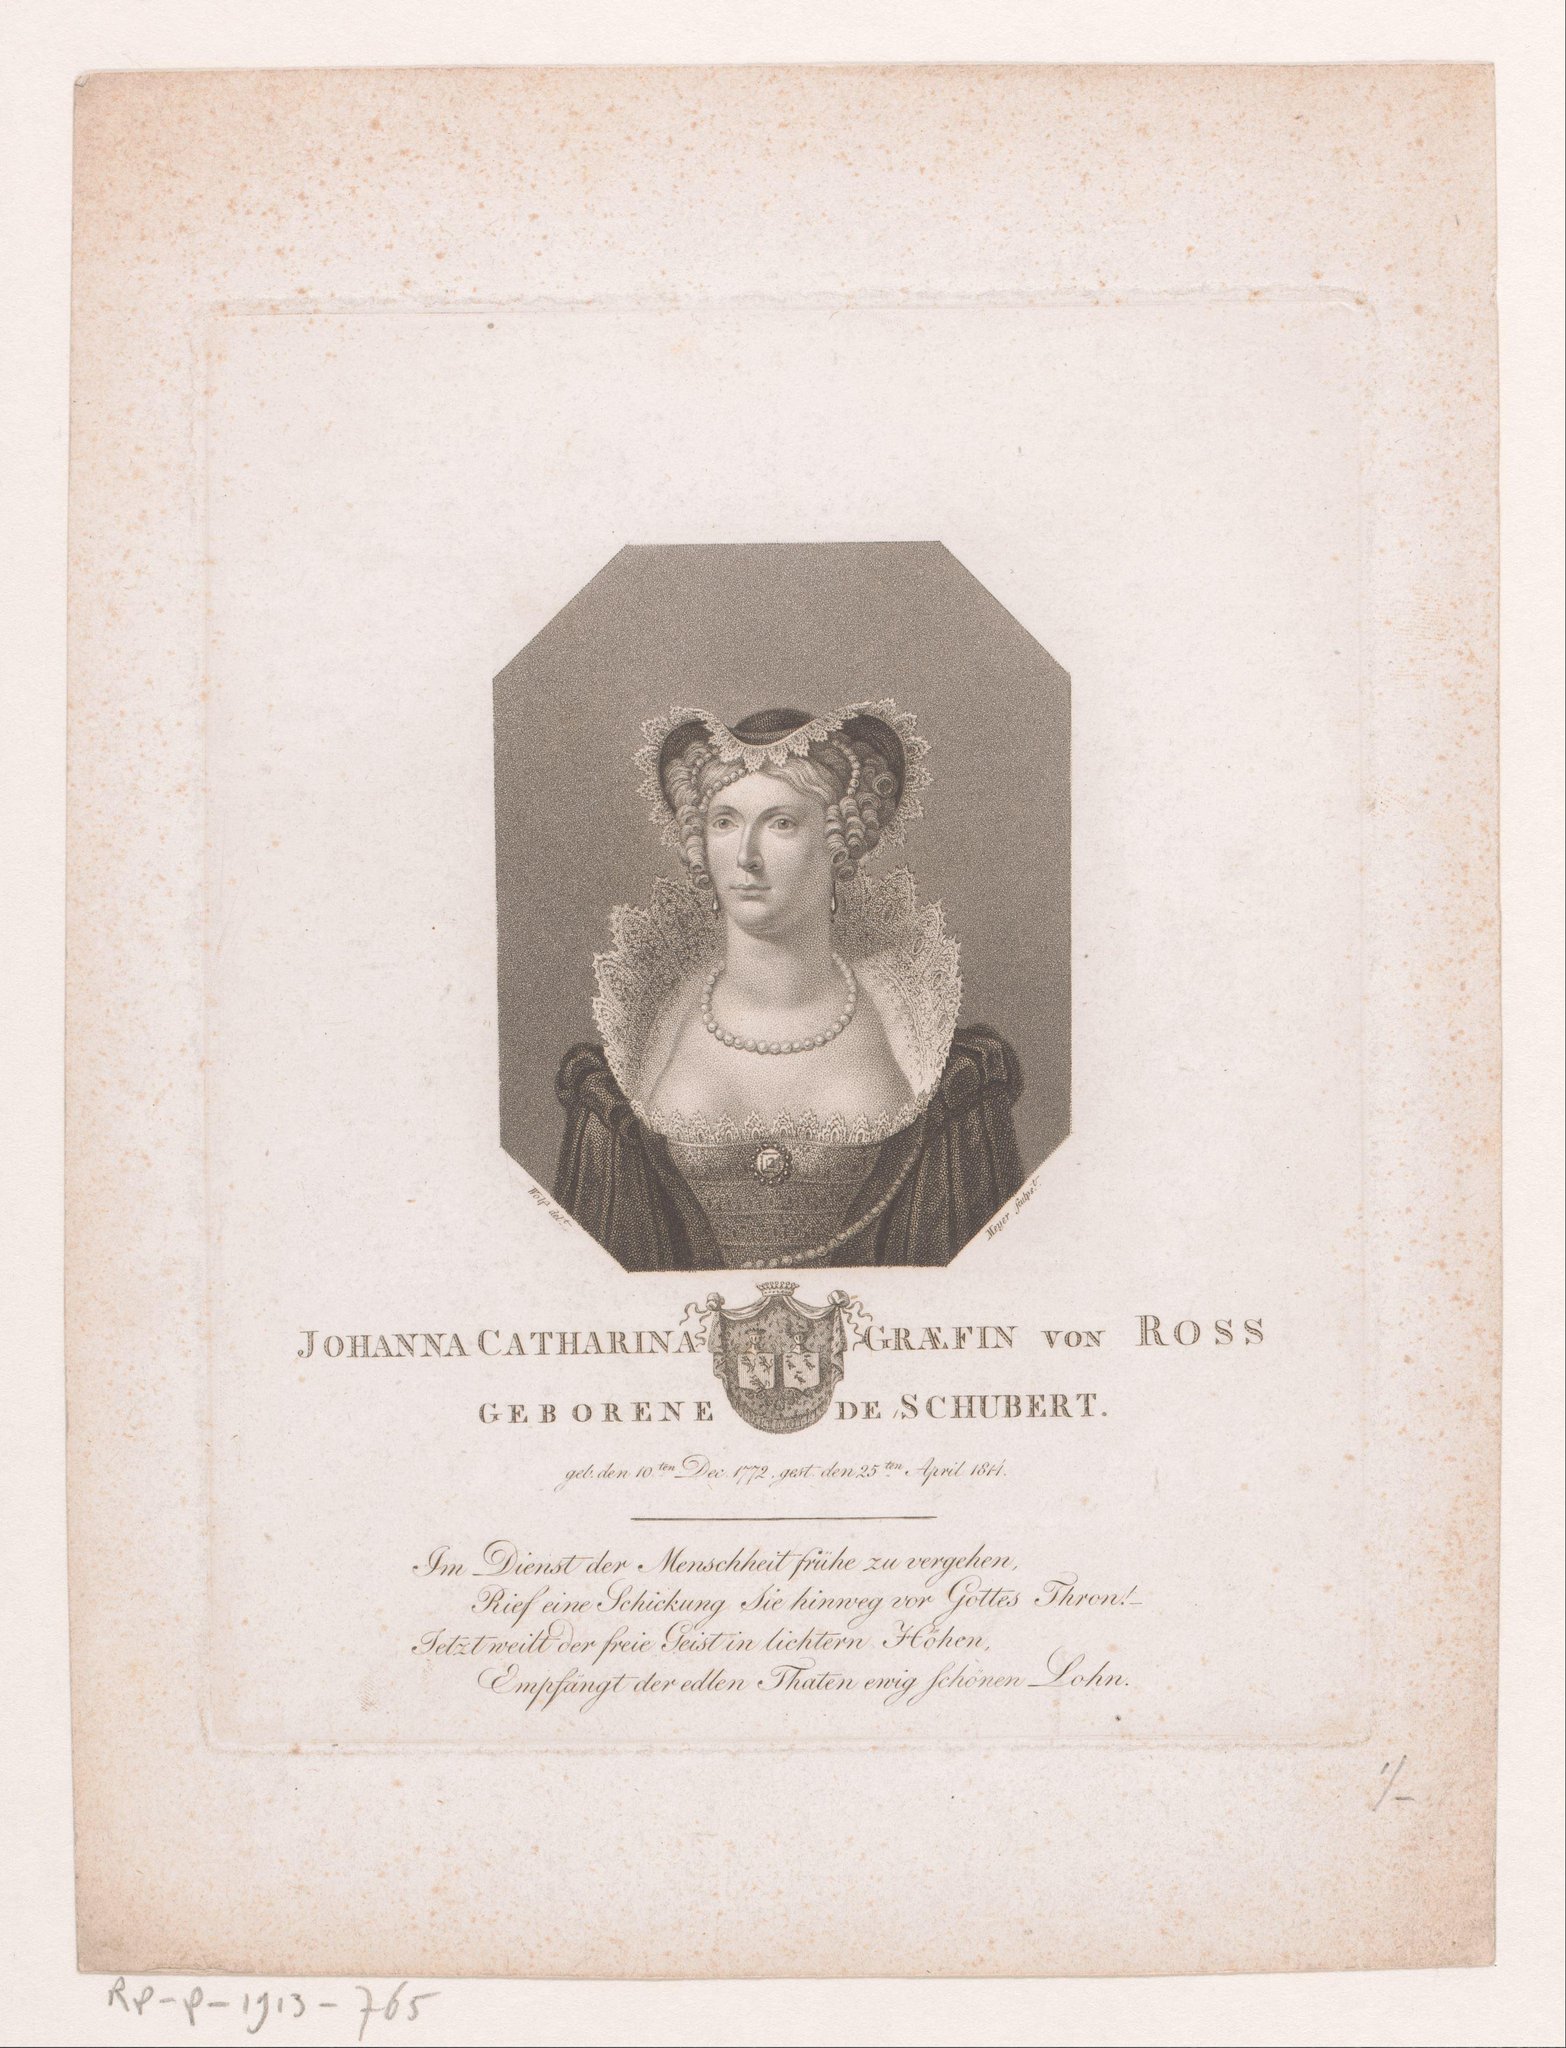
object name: print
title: Portret van Johanna Catharina Schubert, gravin van Ross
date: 1814-1880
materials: paper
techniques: engraving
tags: nijmegen, amsterdam, historical persons - bb - woman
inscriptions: collector's mark: Lugt 2228